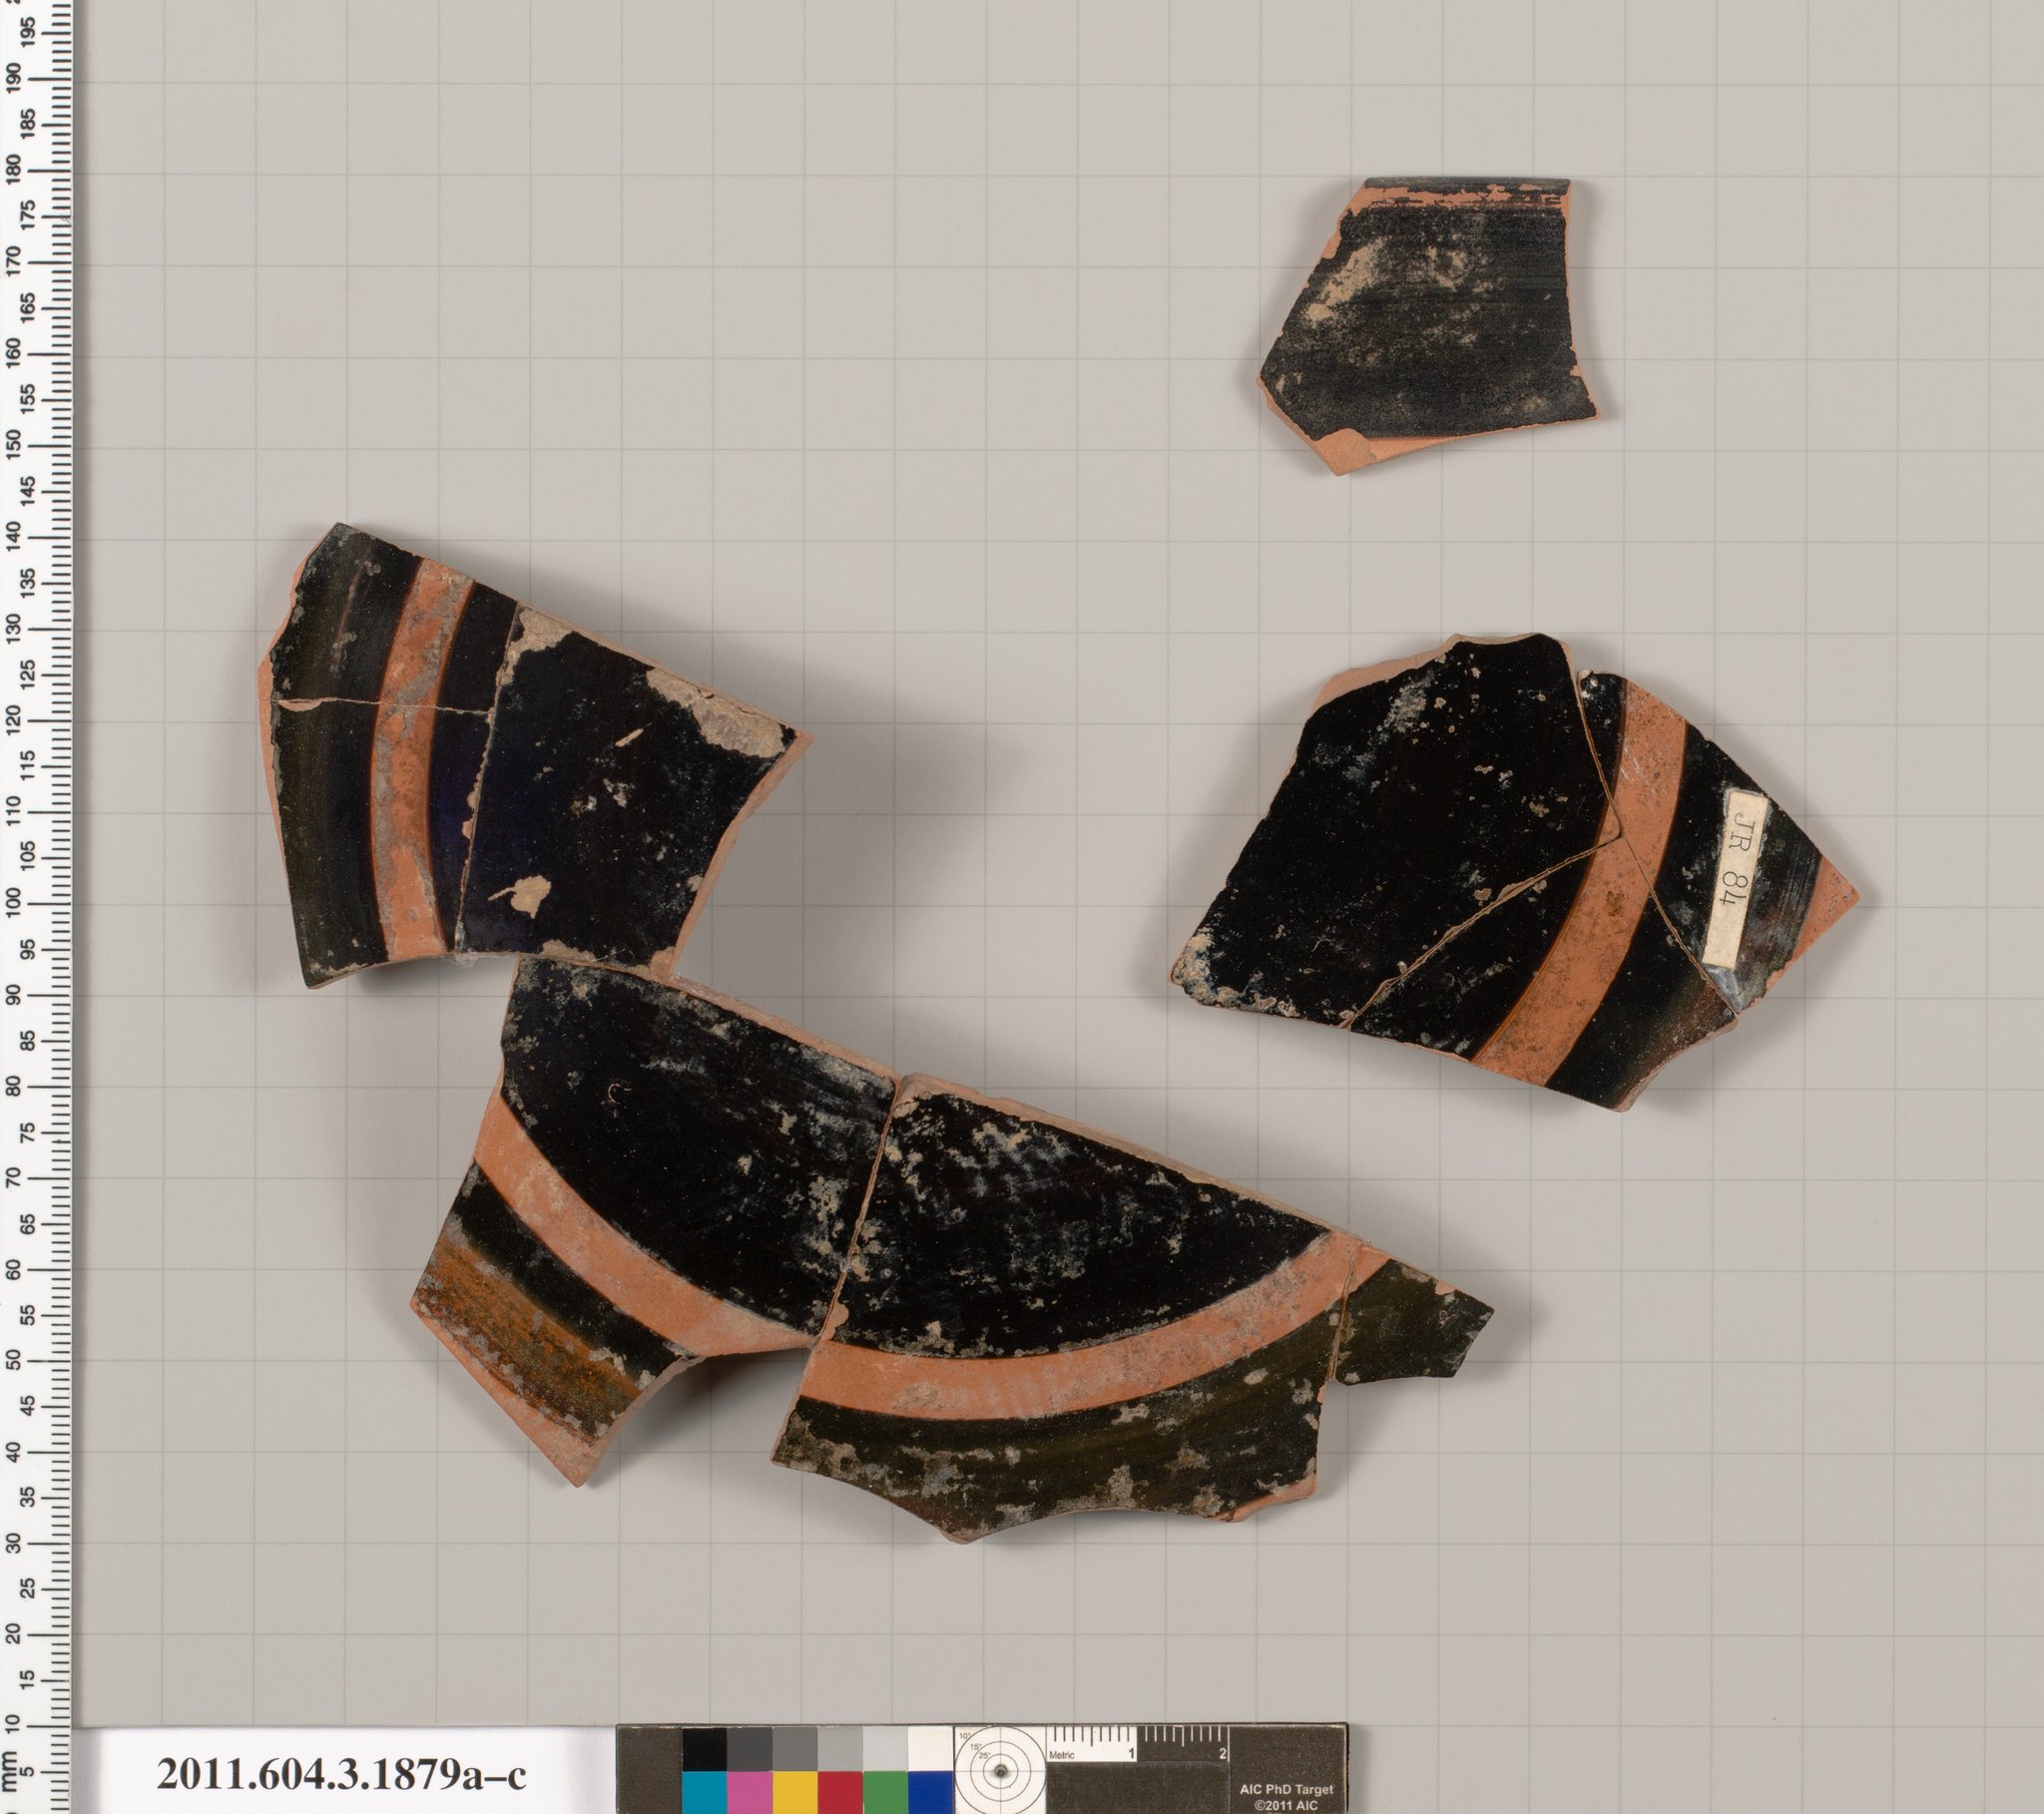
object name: kylix fragment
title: Terracotta fragments of a kylix: Band or lip cup (drinking cup)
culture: greek, attic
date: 550-526 BCE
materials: terracotta